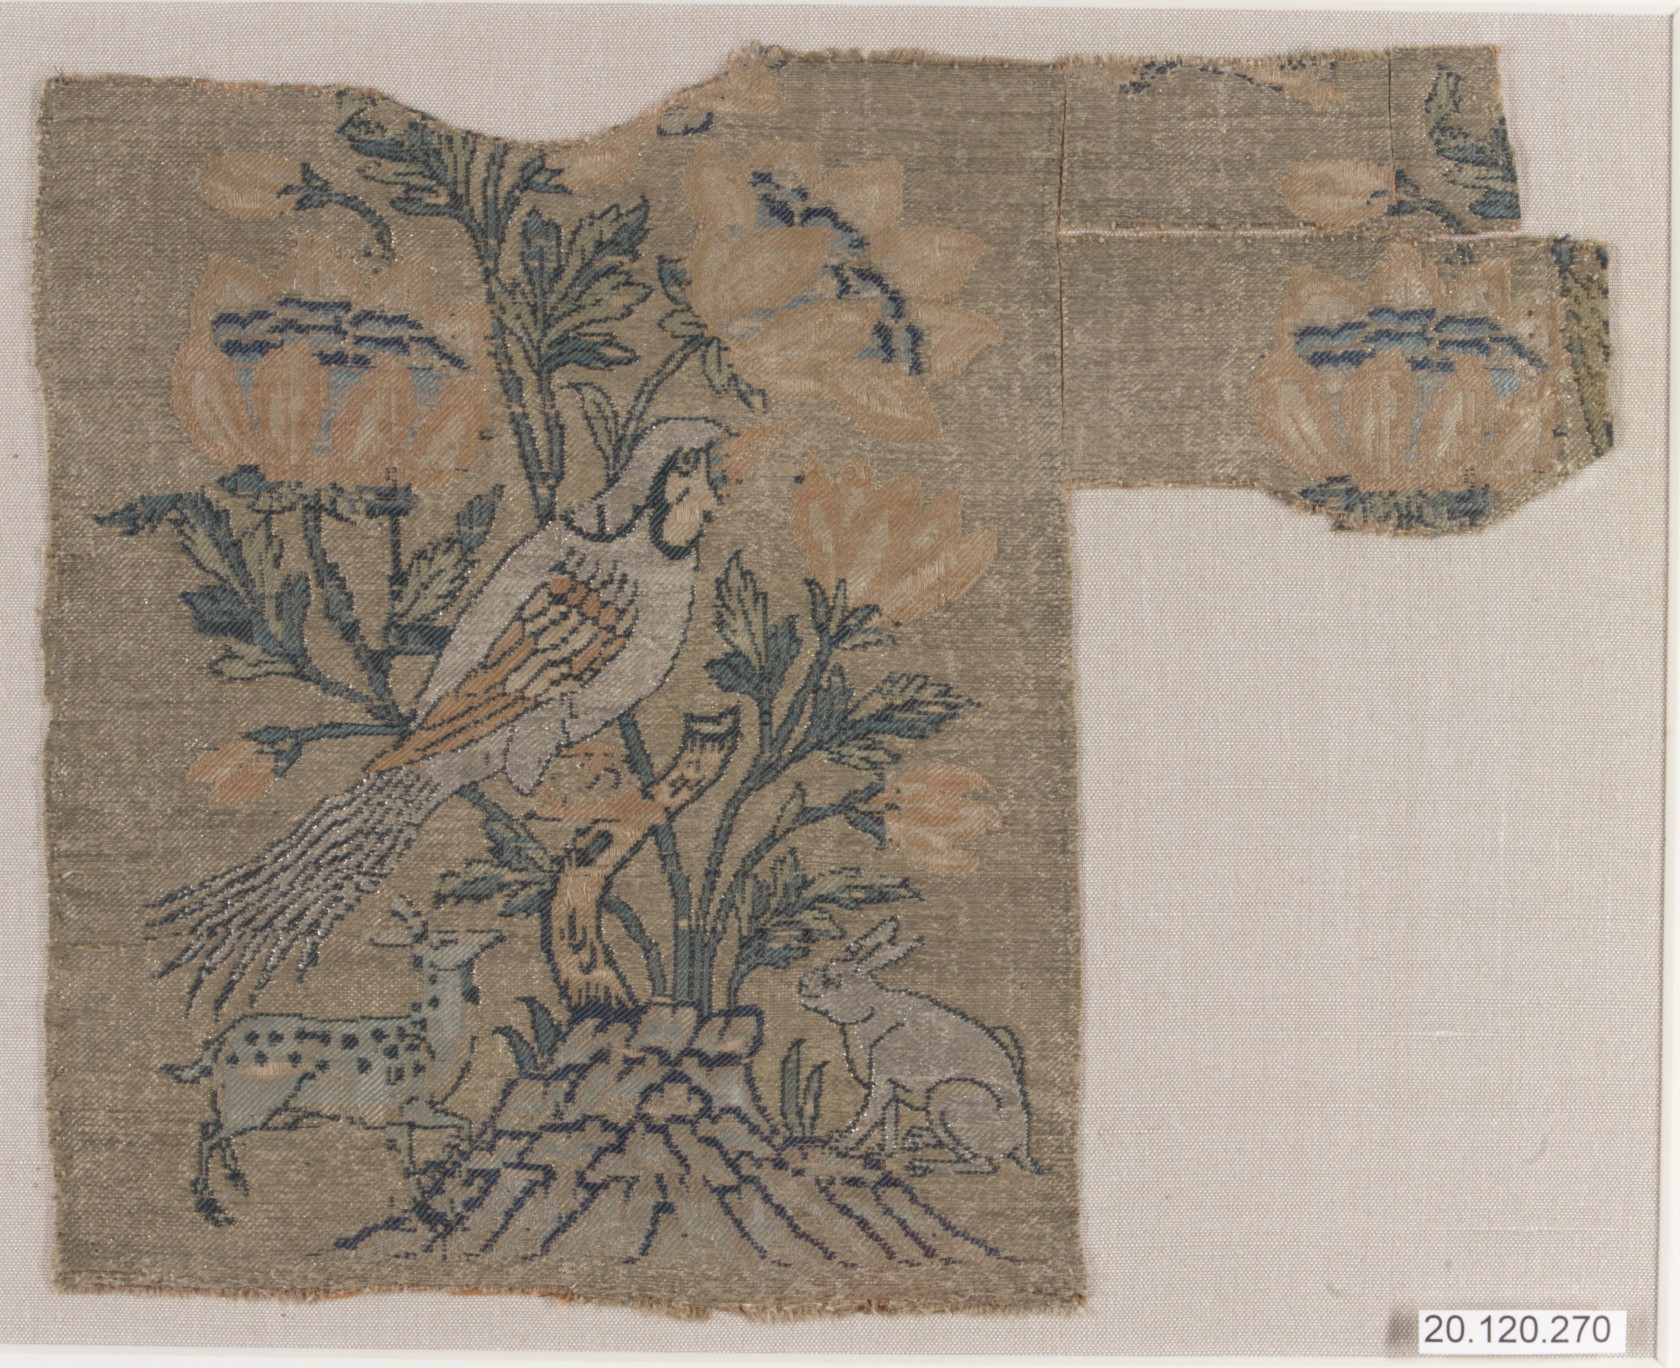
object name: textile fragment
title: Fragment of Garment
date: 1601-1700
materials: silk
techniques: brocade, weave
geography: iran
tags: animals,birds,trees